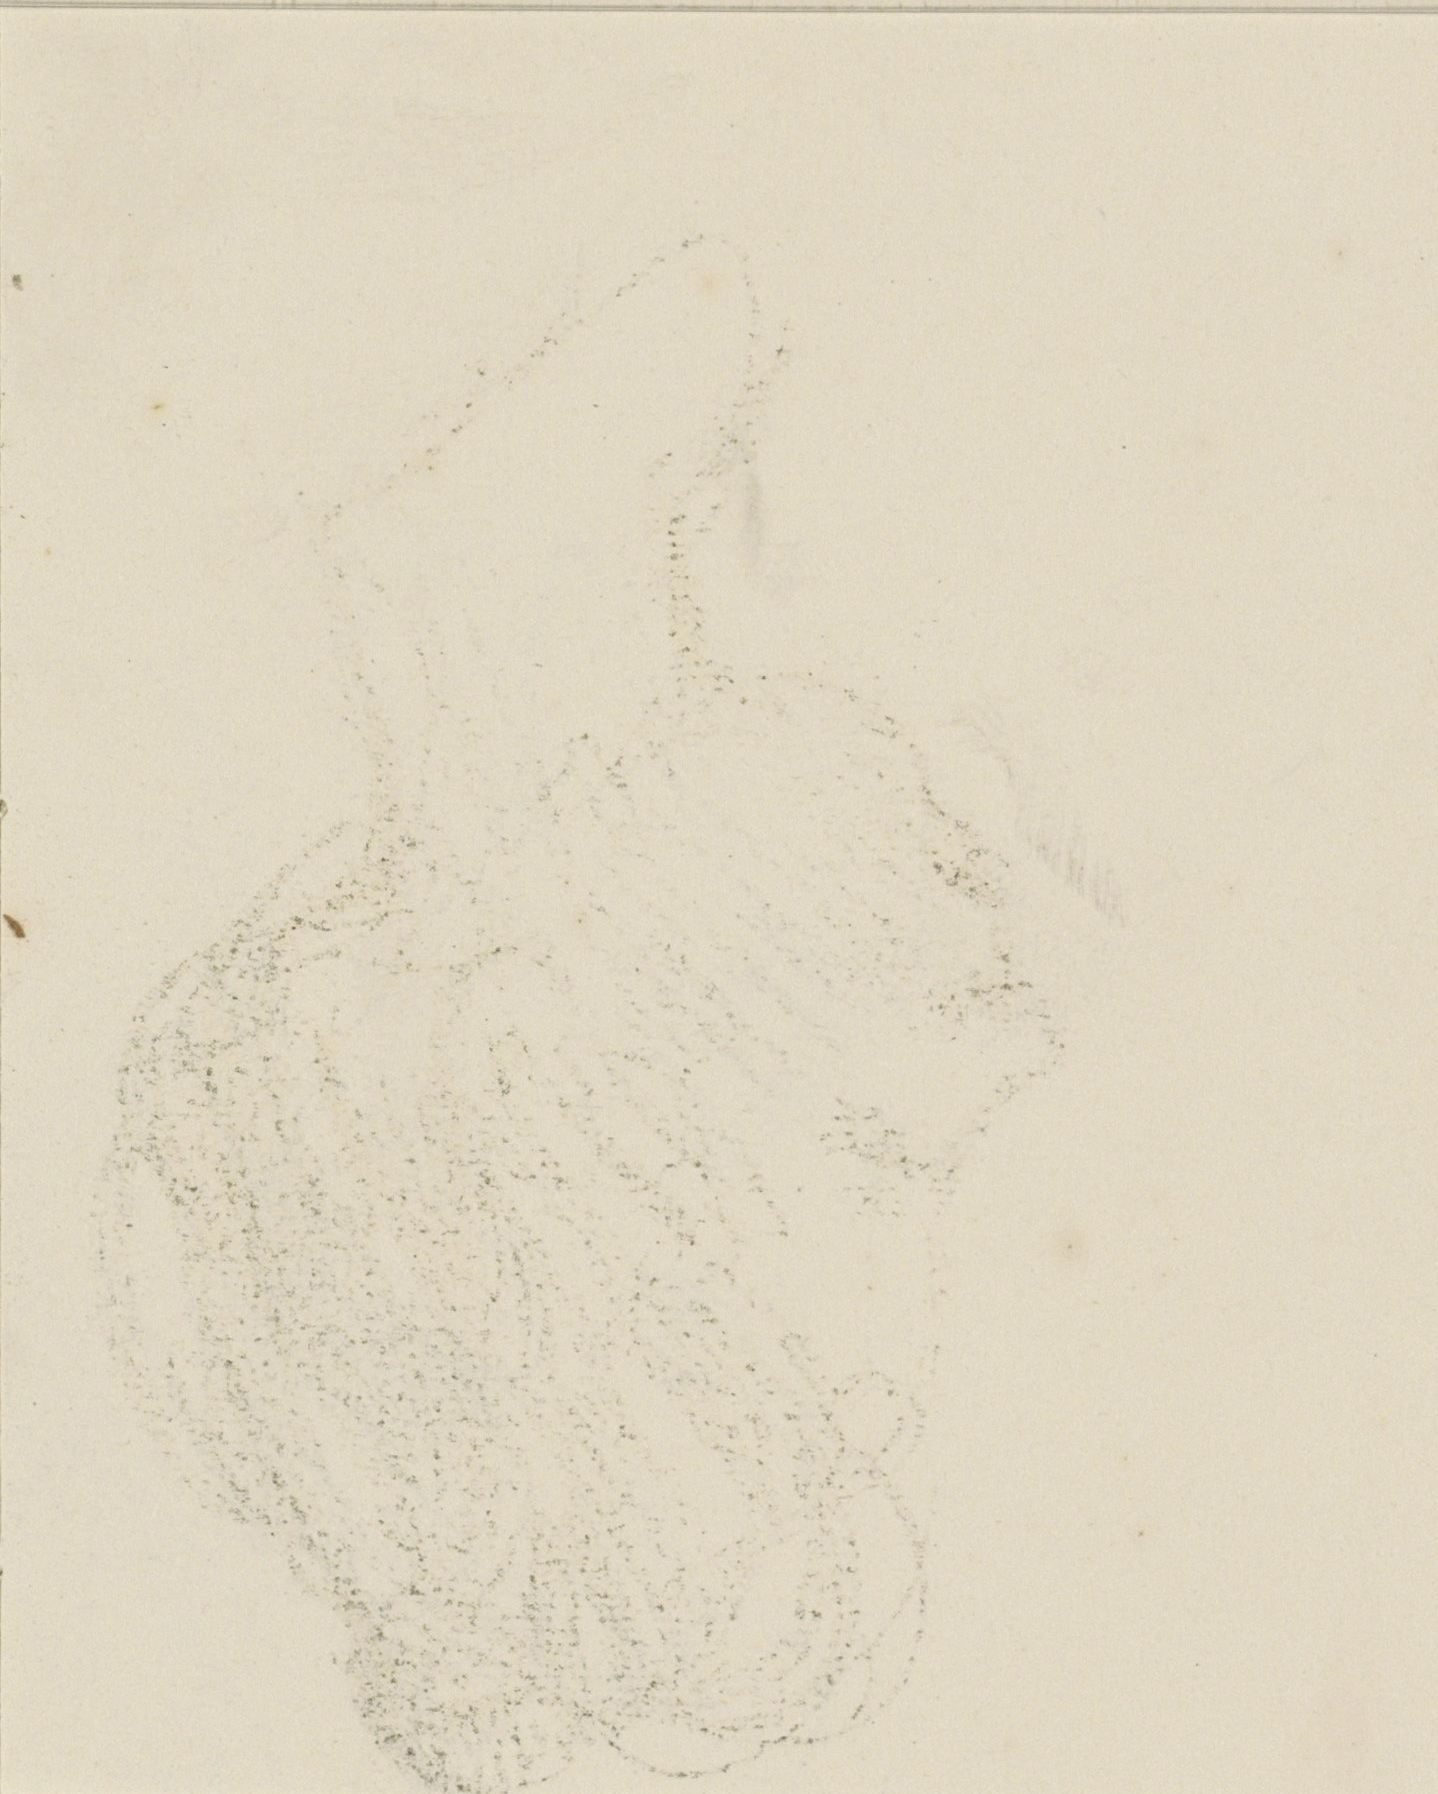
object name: sketchbook leaf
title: Abklatsch van de krijttekening op pagina 52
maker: isaac israels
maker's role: draughtsman, painter, print maker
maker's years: 1865-1934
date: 1886-1903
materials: paper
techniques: printmaking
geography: amsterdam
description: Pagina 53 uit schetsboek XXXII met 92 pagina's.